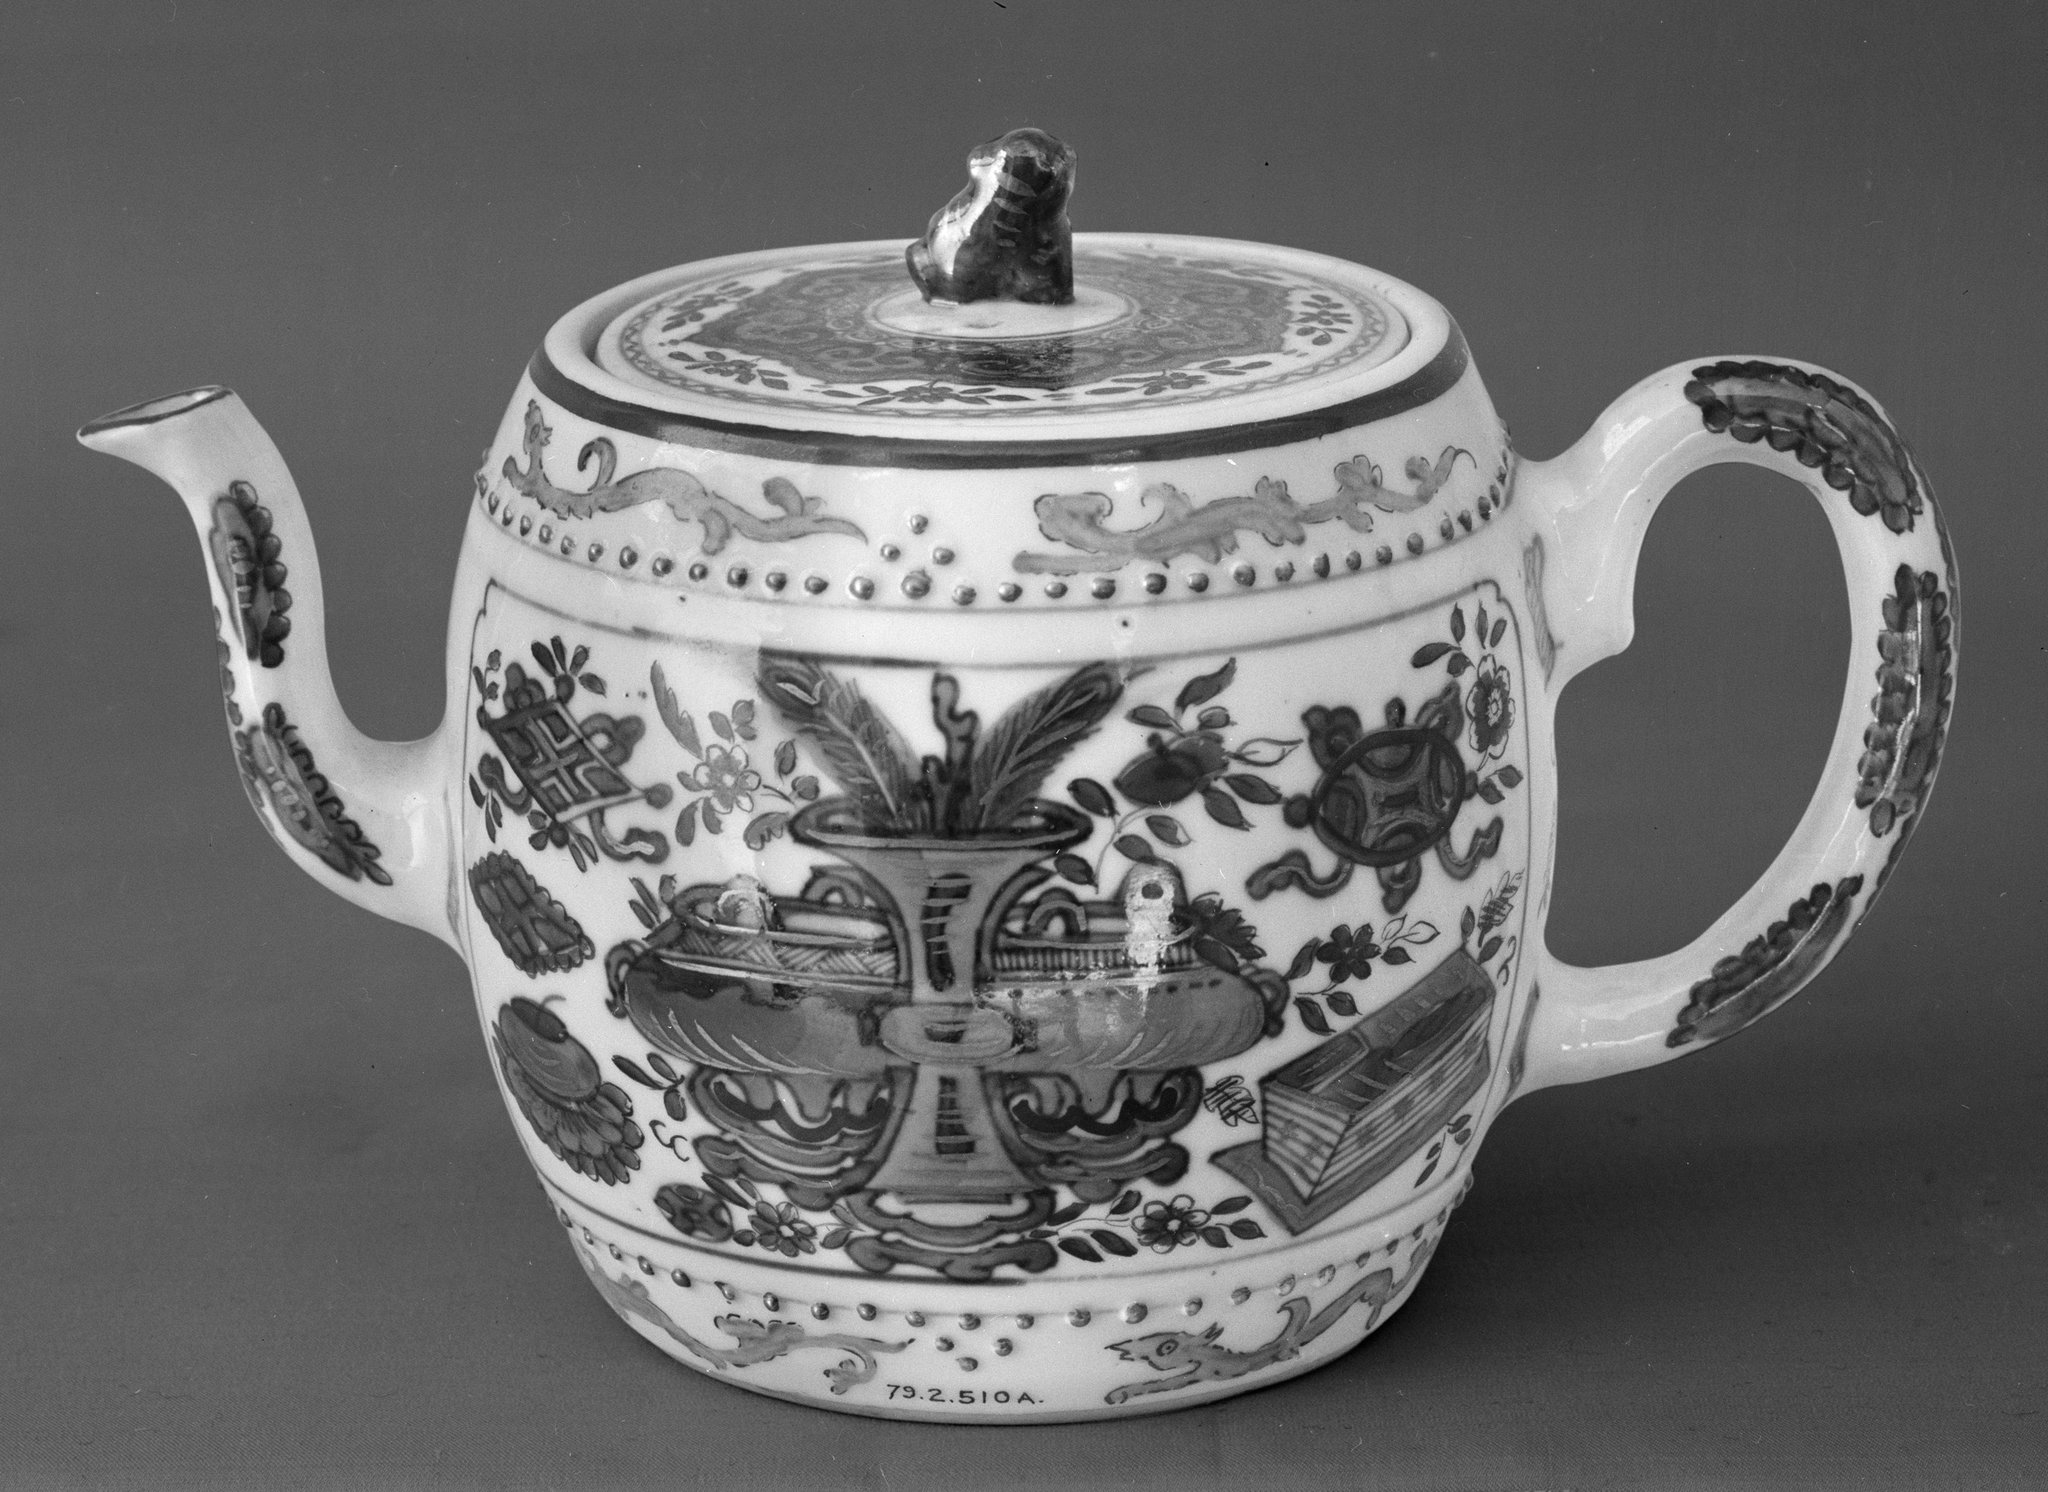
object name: teapot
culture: chinese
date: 1667-1733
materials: enamel, porcelain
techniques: overglaze, painting, polychrome, underglaze